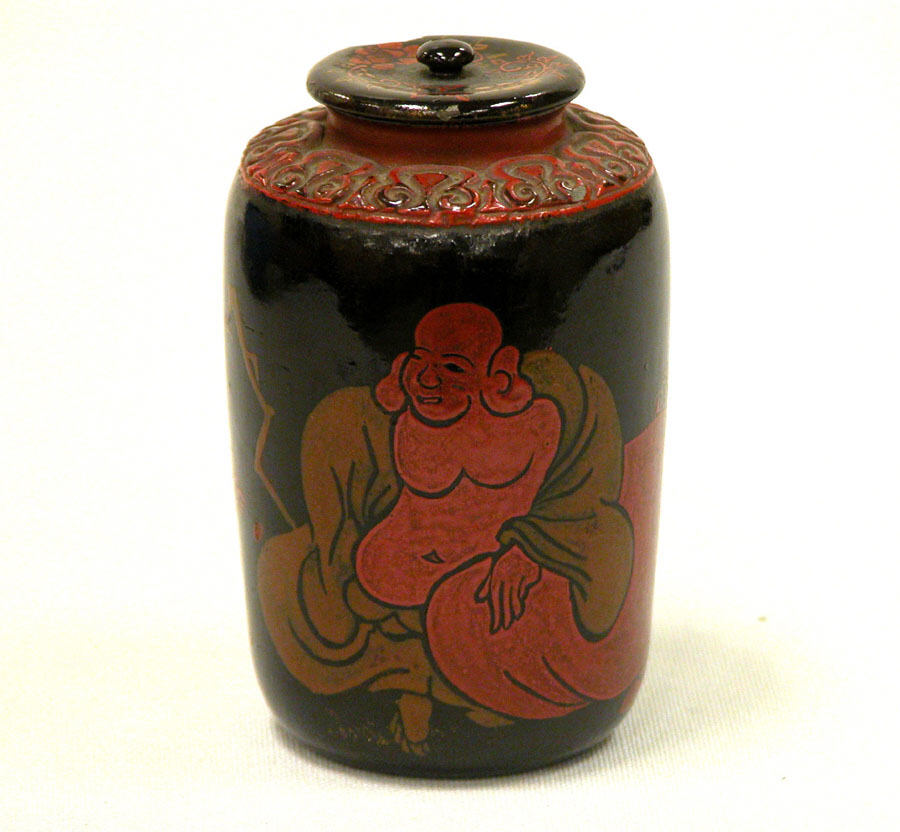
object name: tea jar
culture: japanese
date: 1573-1615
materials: lacquer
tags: men